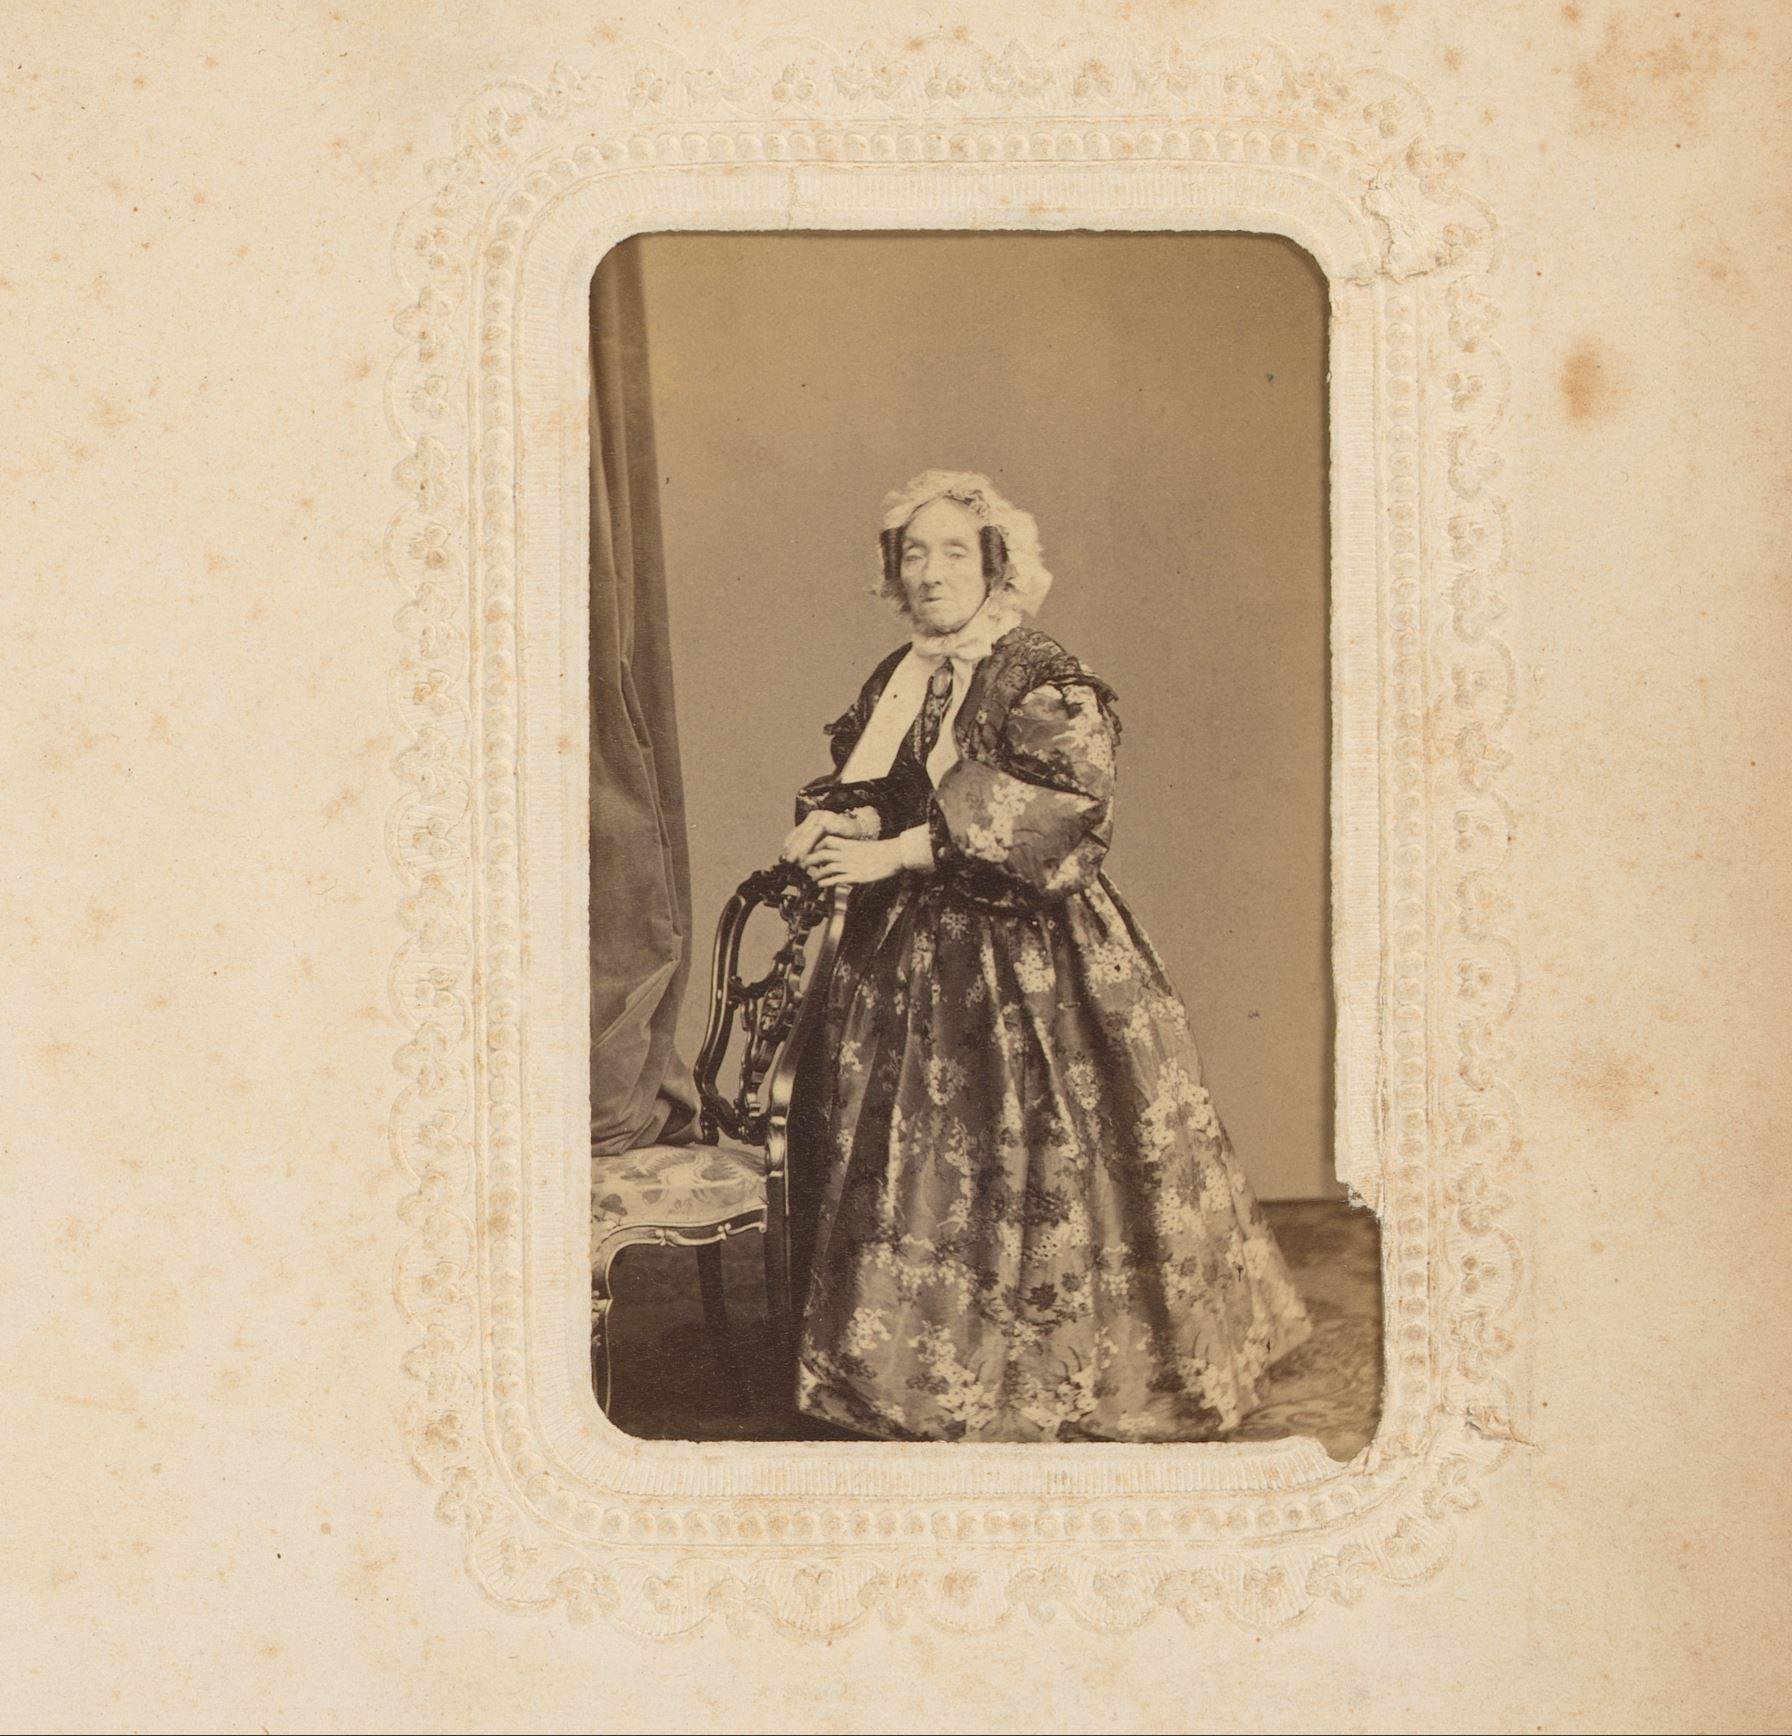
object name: album leaf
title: Portret van een oude vrouw met muts, staand bij een stoel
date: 1862-1863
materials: cardboard, photographic support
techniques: albumen print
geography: brussels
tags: historical persons - bb - woman, head-gear: hat, standing figure - aa - female human figure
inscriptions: inscription: ‘Etablissement Photographique/ de Maes & Michaux/ Place de la Monnaie, 36, Rue Fossé-aux-Loups/ Bruxelles’